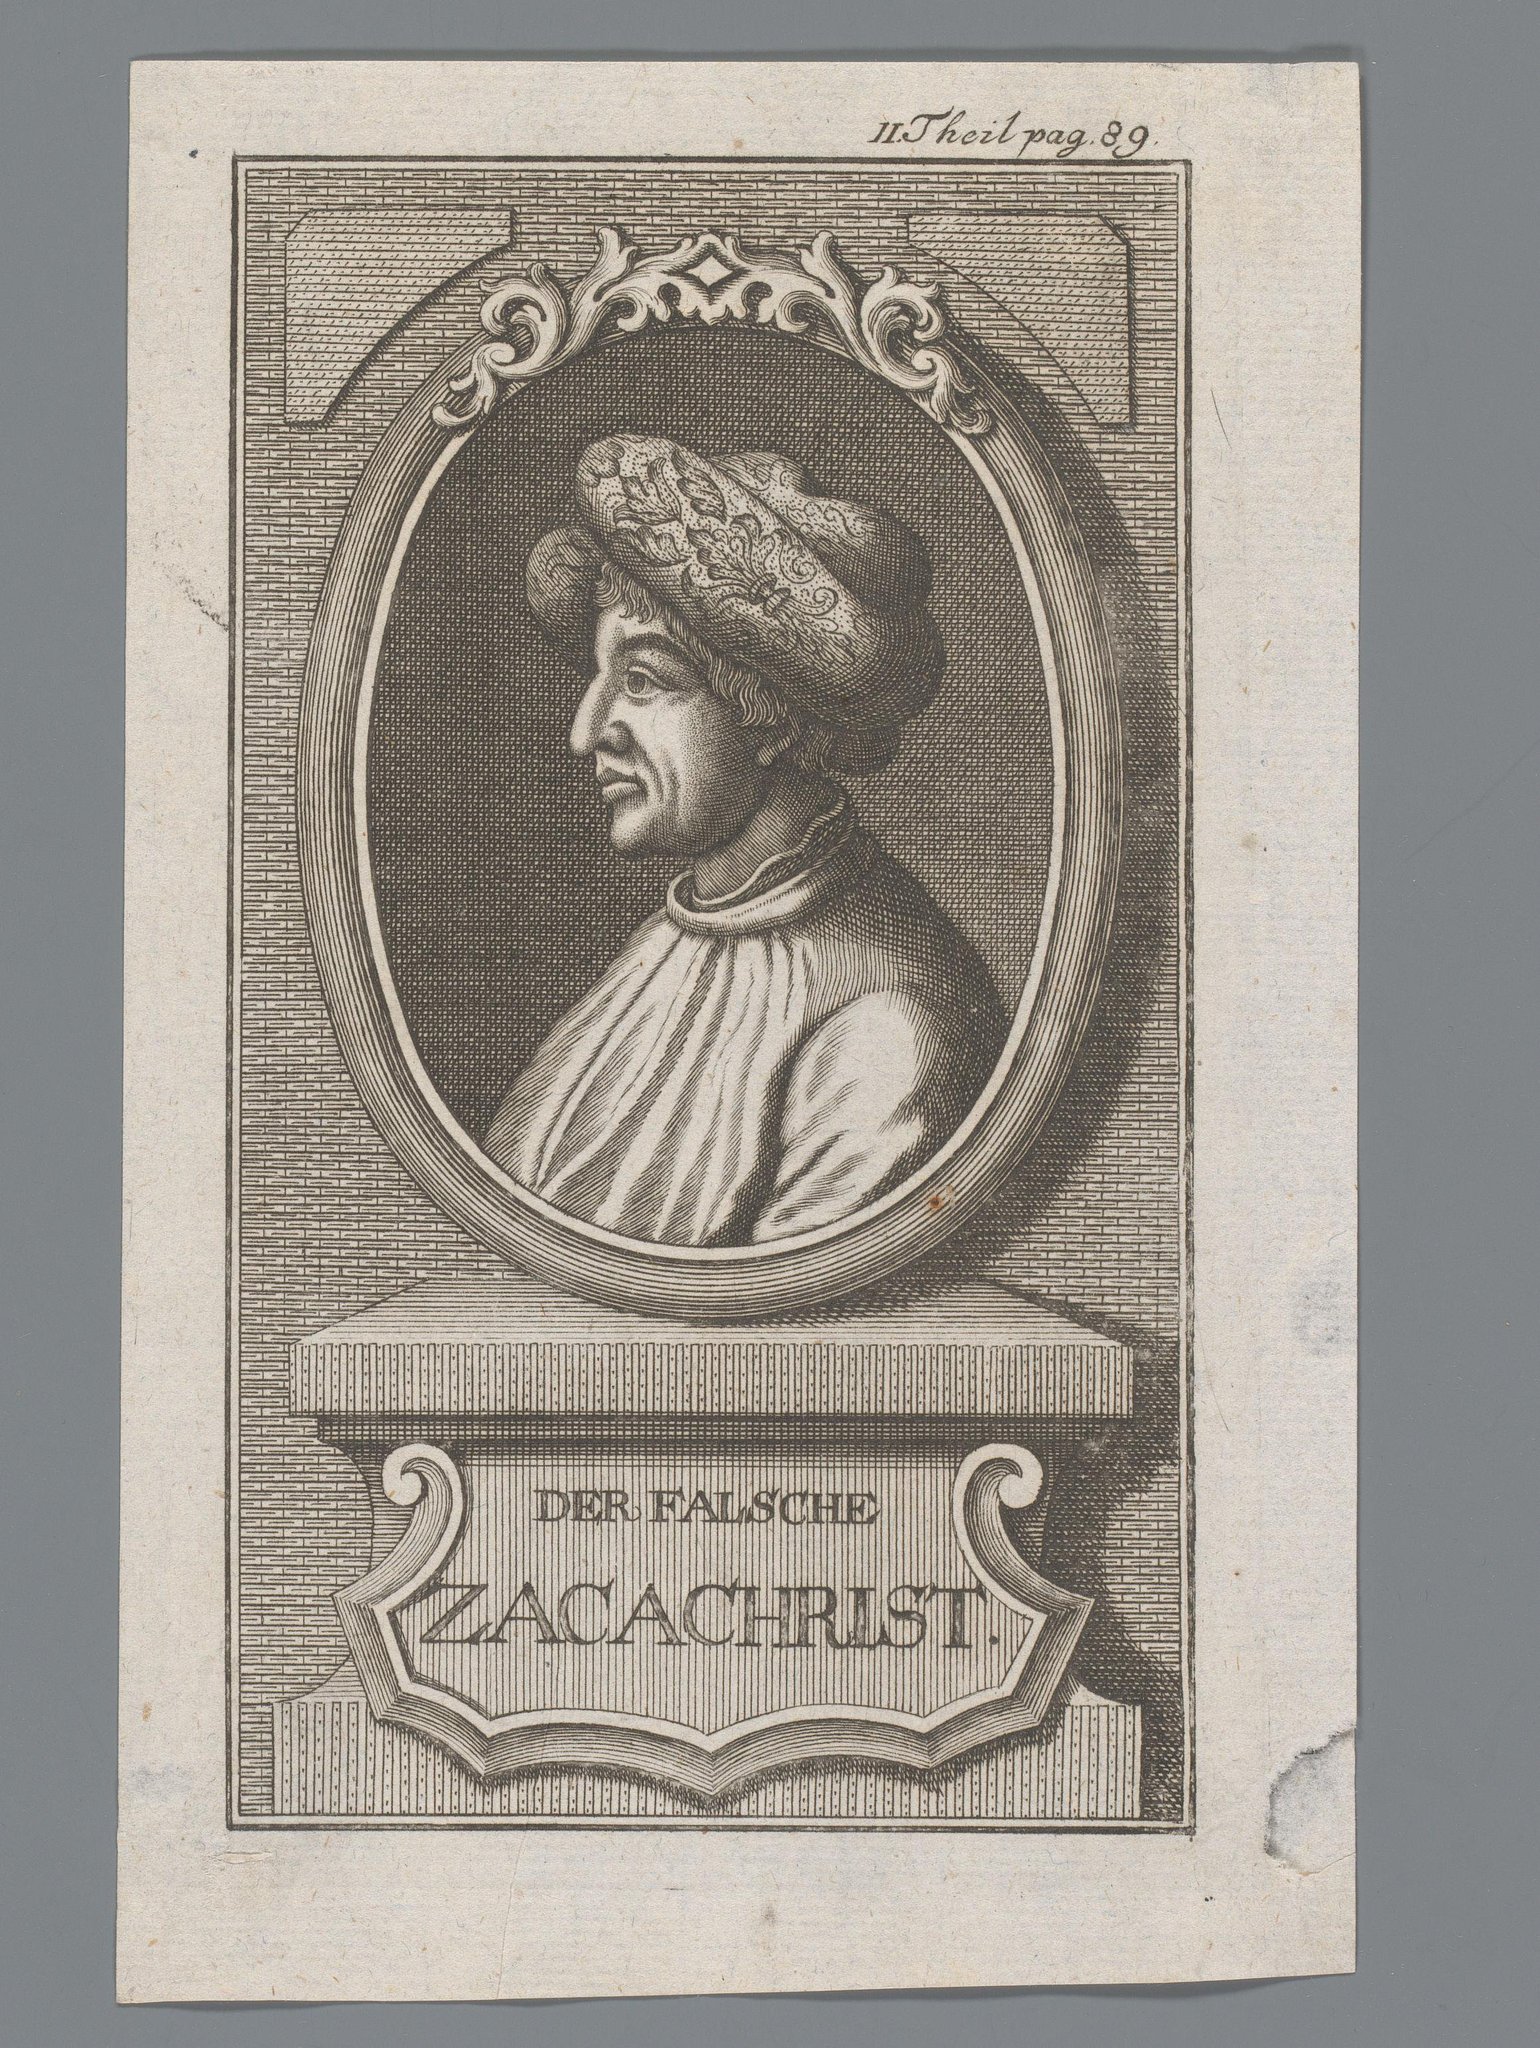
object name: print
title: Portret van Zaga Christ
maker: Anonymous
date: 1761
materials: paper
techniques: engraving, etching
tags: politician, historical persons, politician, e.g. party leader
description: Prent waarschijnlijk uit: Rocolos, Jean-Baptiste de. Geschichte merkwürdiger Betrüger. Halle: J.J. Curts, 1761, dl. 2, p. 89.